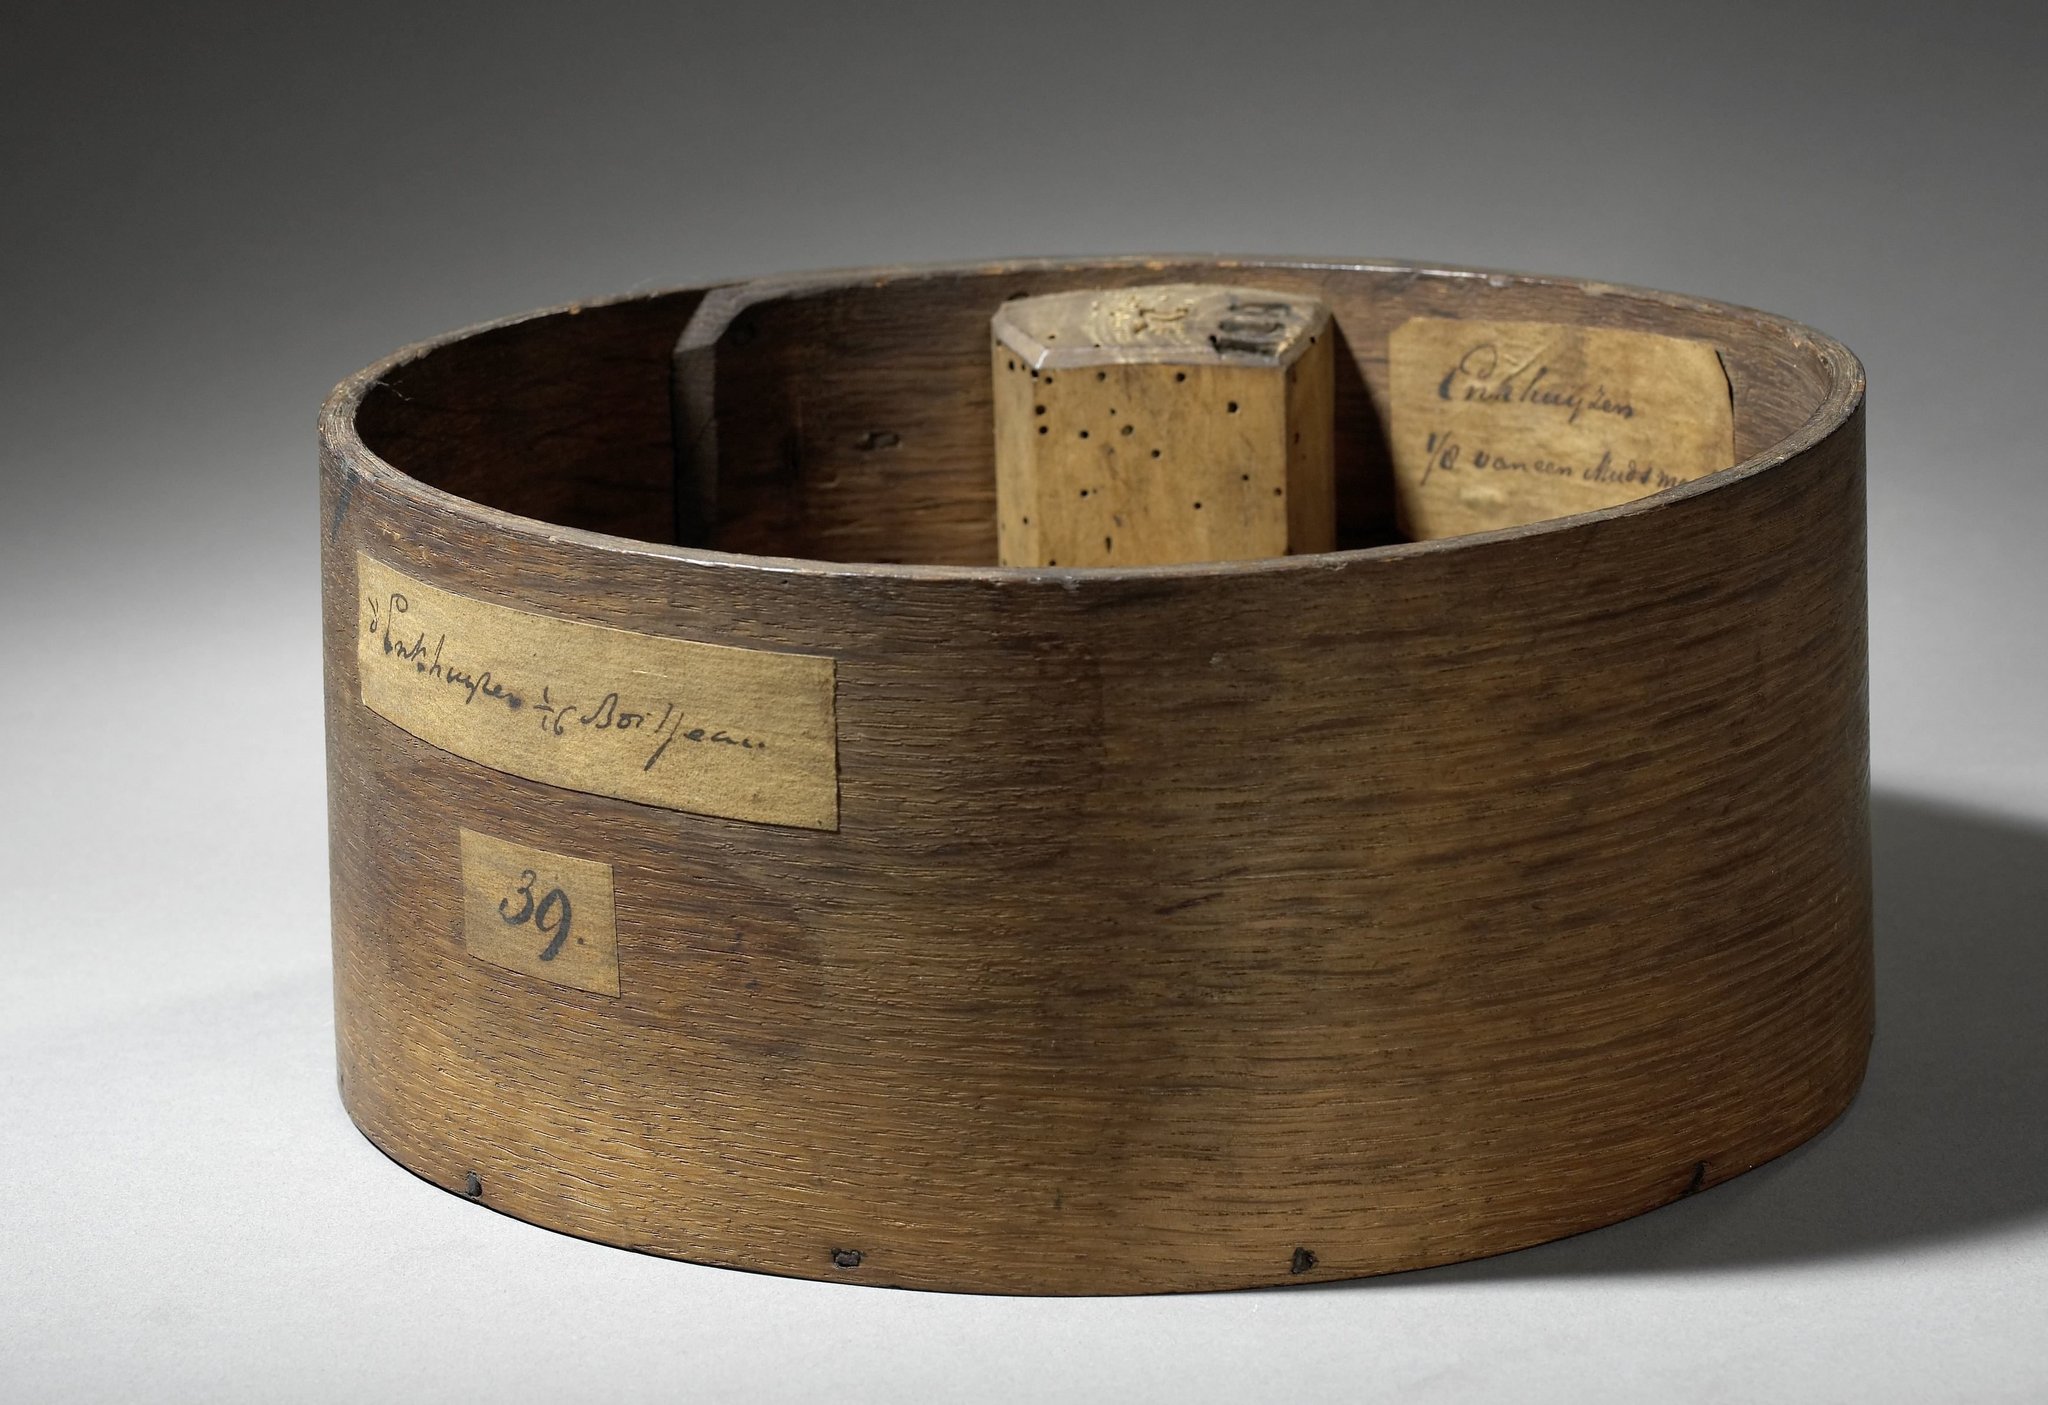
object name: inhoudsmaat droge waren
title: Maat van een achtste mud van Enhuizen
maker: Anonymous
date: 1800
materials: wood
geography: enkhuizen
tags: enkhuizen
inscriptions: title: ‘Enkhuysen 1/8 van een mudsmaat’, number: ‘39’, : ‘1800’, title: ‘d'Enkhuysen 1/16 Beisjeau’, mark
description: Spanen maat van een achtste mud met blok aan de binnenzijde, voorzien van merken, 2 etiketten en label aan lintje.